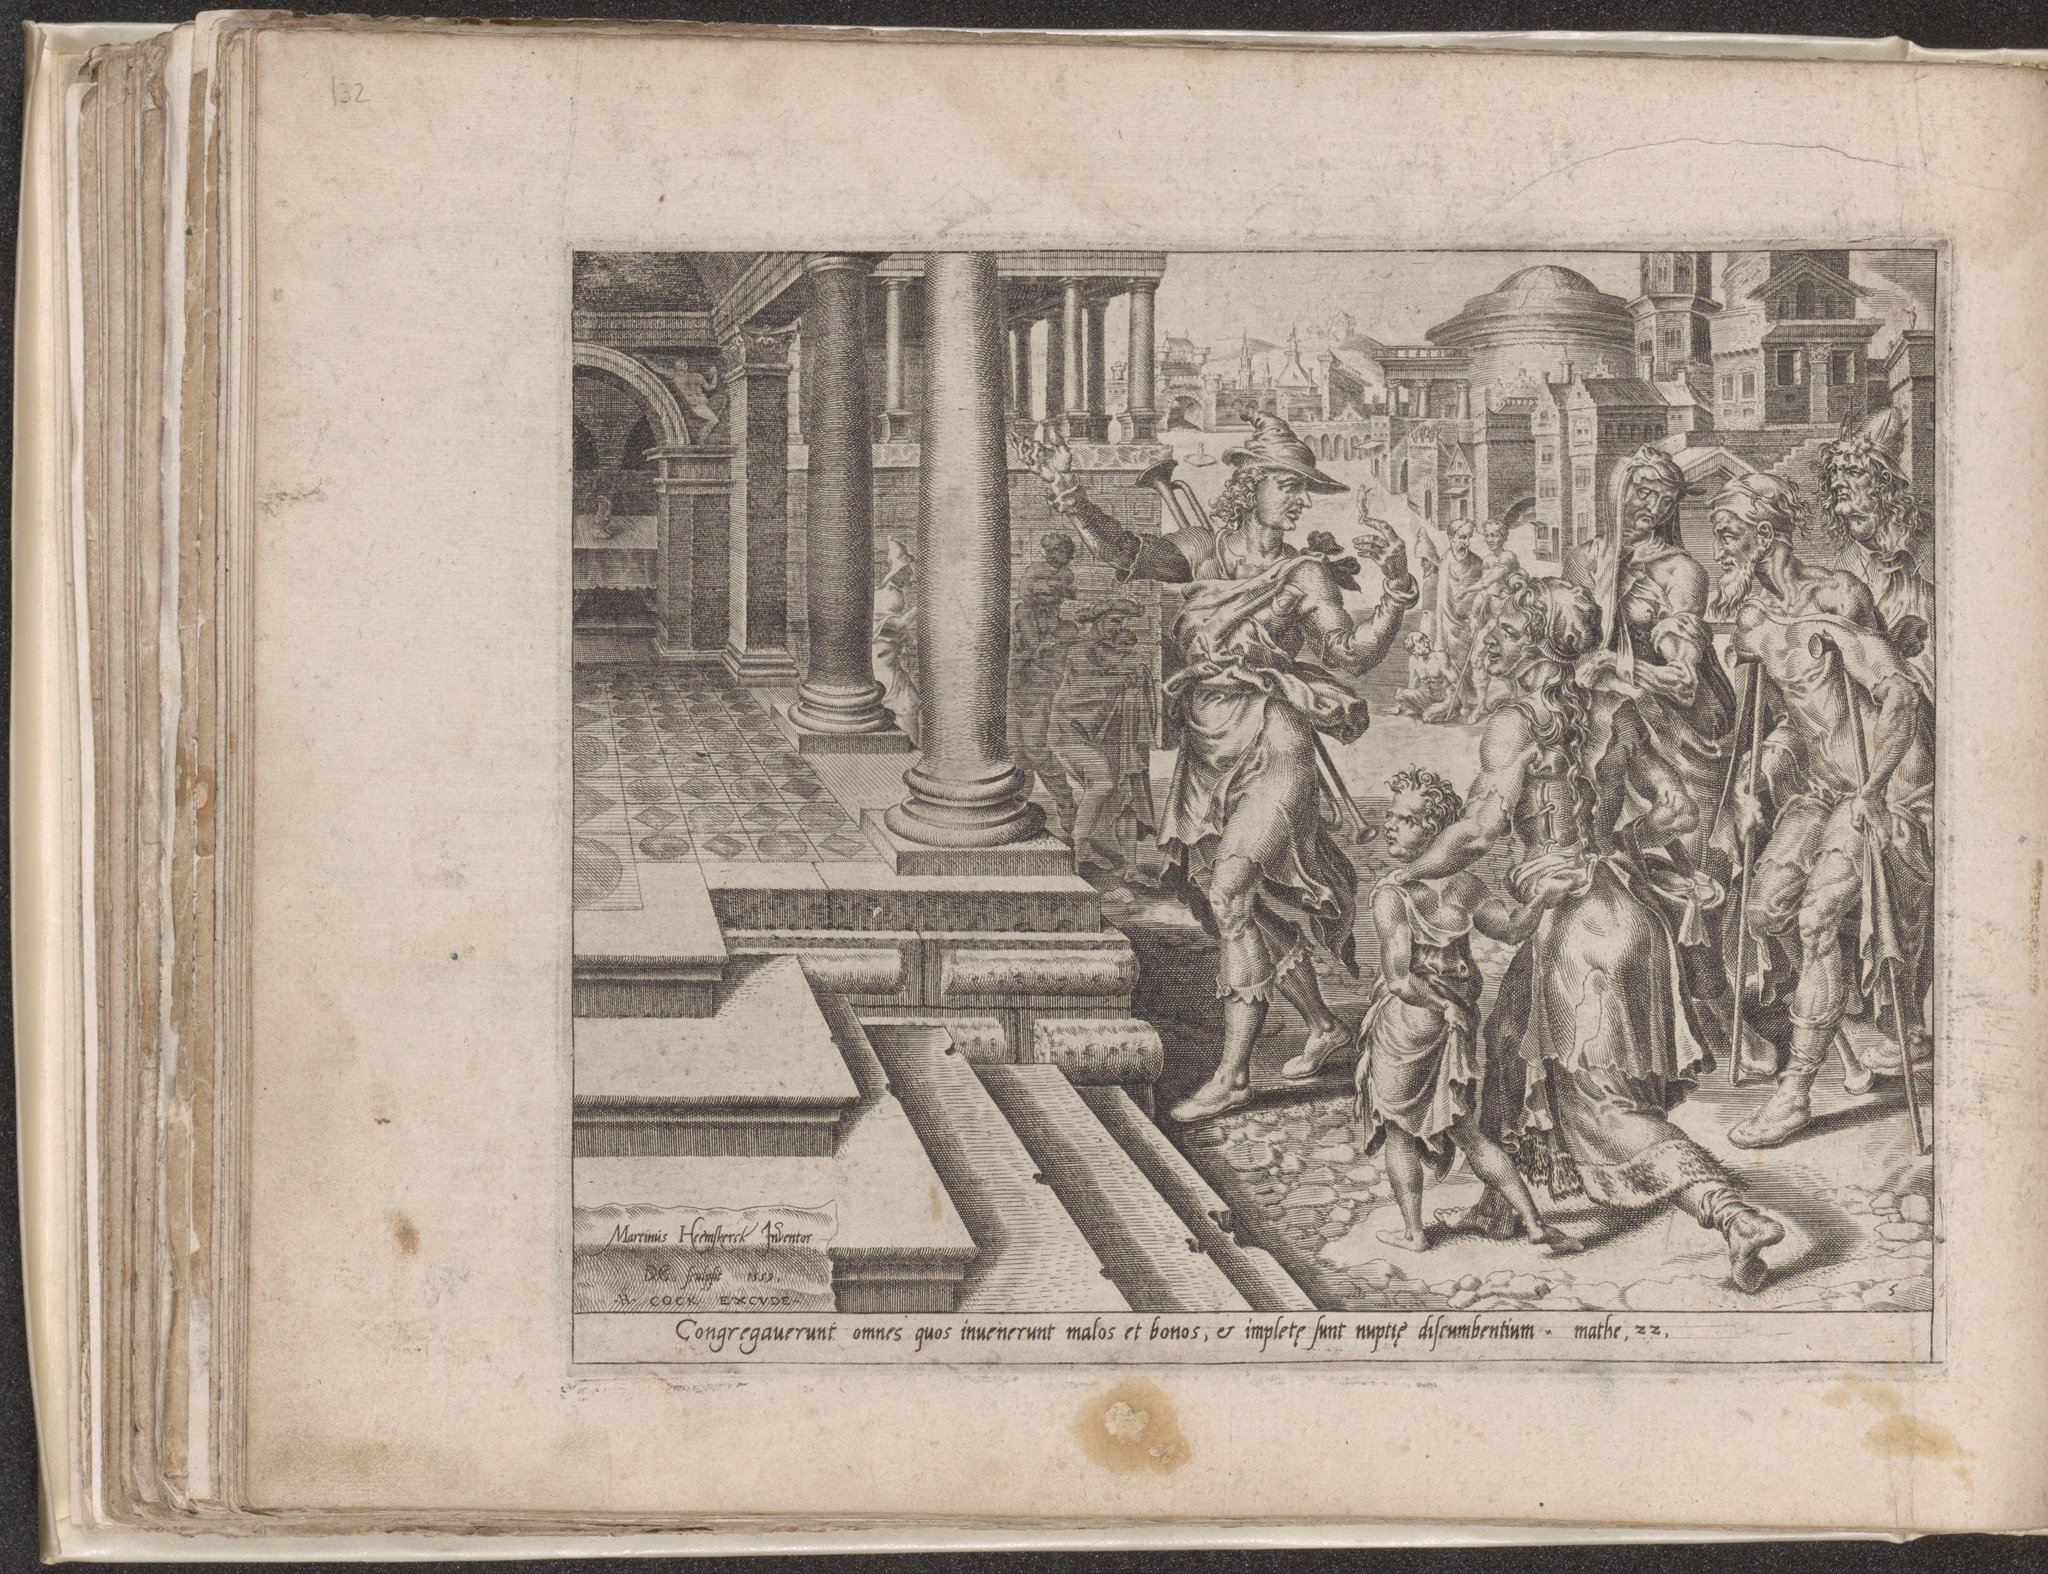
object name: print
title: Uitnodiging van de zieken en armen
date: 1559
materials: paper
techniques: engraving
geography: antwerp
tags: crutches, disabilities, deformations, poor, maimed, blind and lame are brought in, and sit down at the table ~ parable of the royal wedding-feast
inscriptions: date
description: De dienaar van de koning nodigt de mensen van de straat uit voor het bruiloftsfeest. Arme, zieke en kreupele mensen volgen de dienaar naar de feestzaal. Onder de voorstelling een verwijzing in het Latijn naar de Bijbeltekst in Mat. 22. Deze prent maakt deel uit van een album.